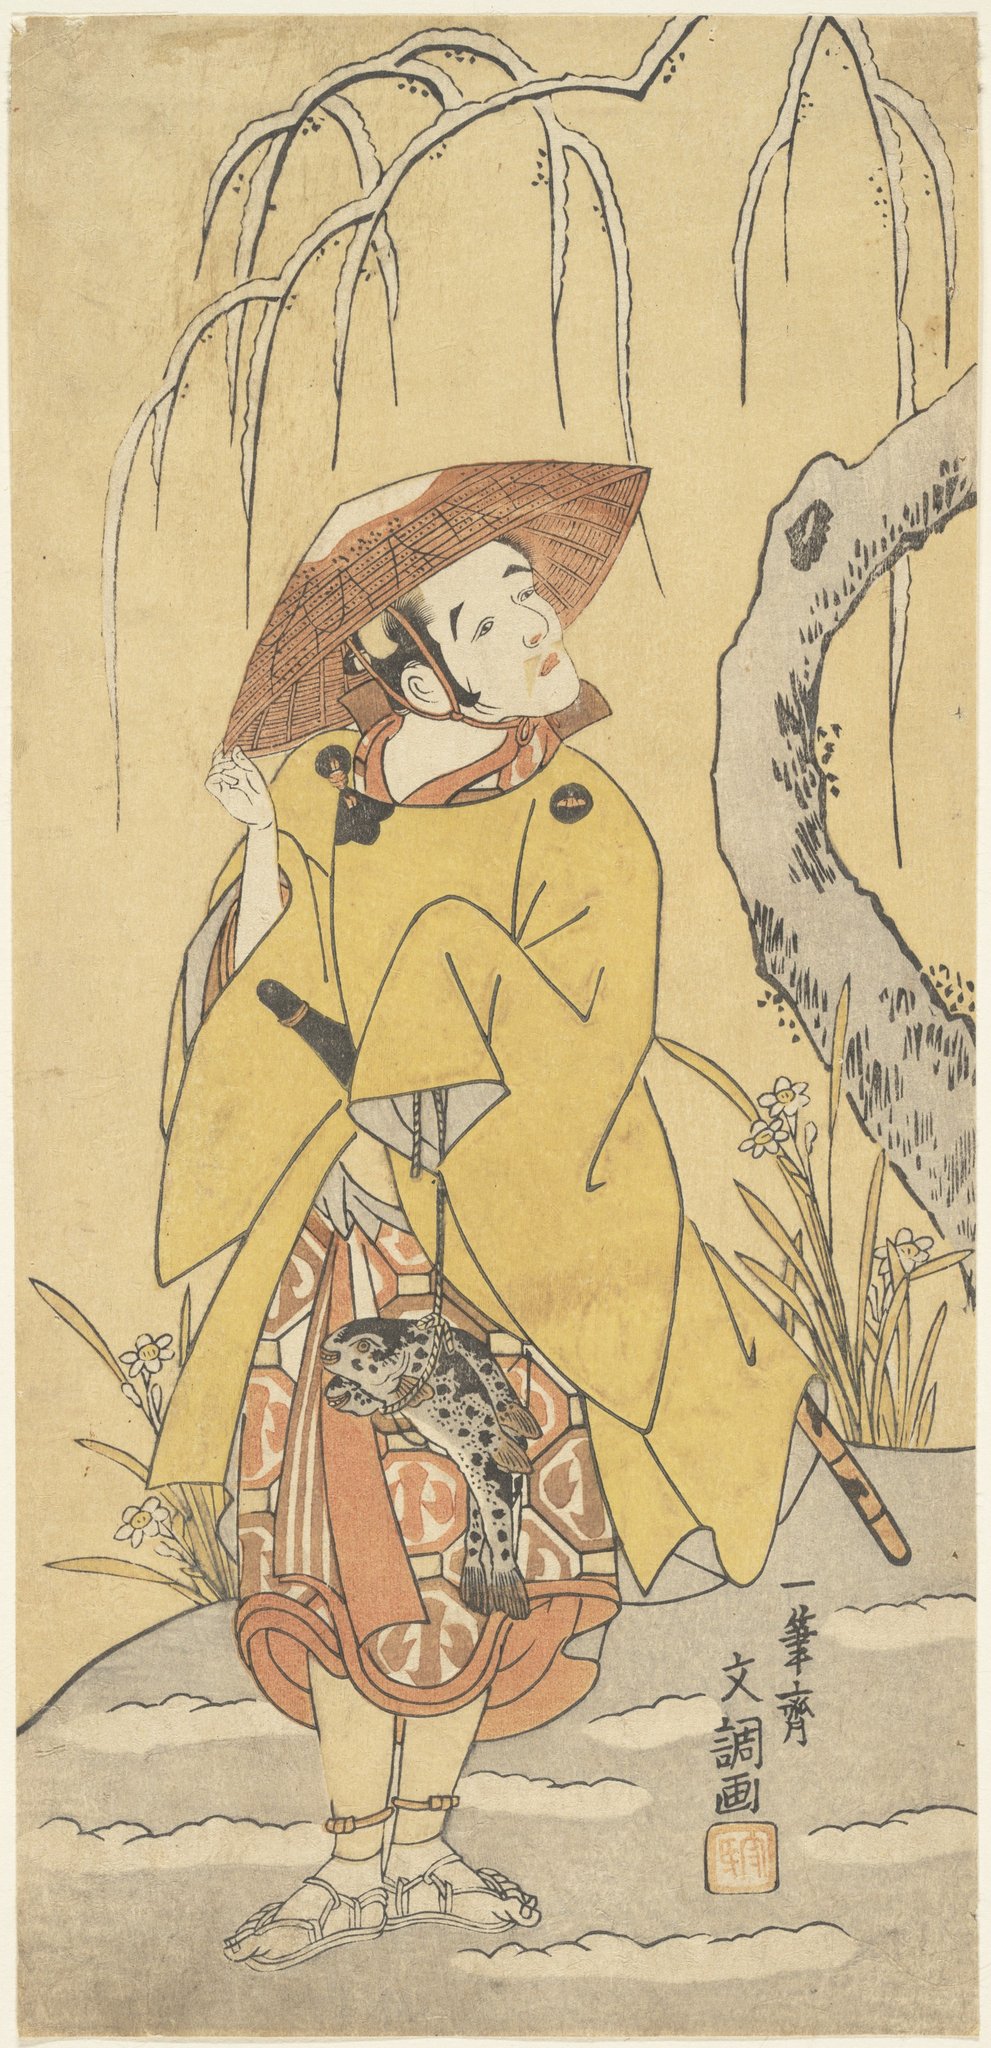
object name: print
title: Arashi Otohachi I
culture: japanese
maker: ippitsusai bunchō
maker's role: artist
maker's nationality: japanese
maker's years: 1765-1792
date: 1790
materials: ink, paper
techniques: woodblock print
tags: fish,trees,actors